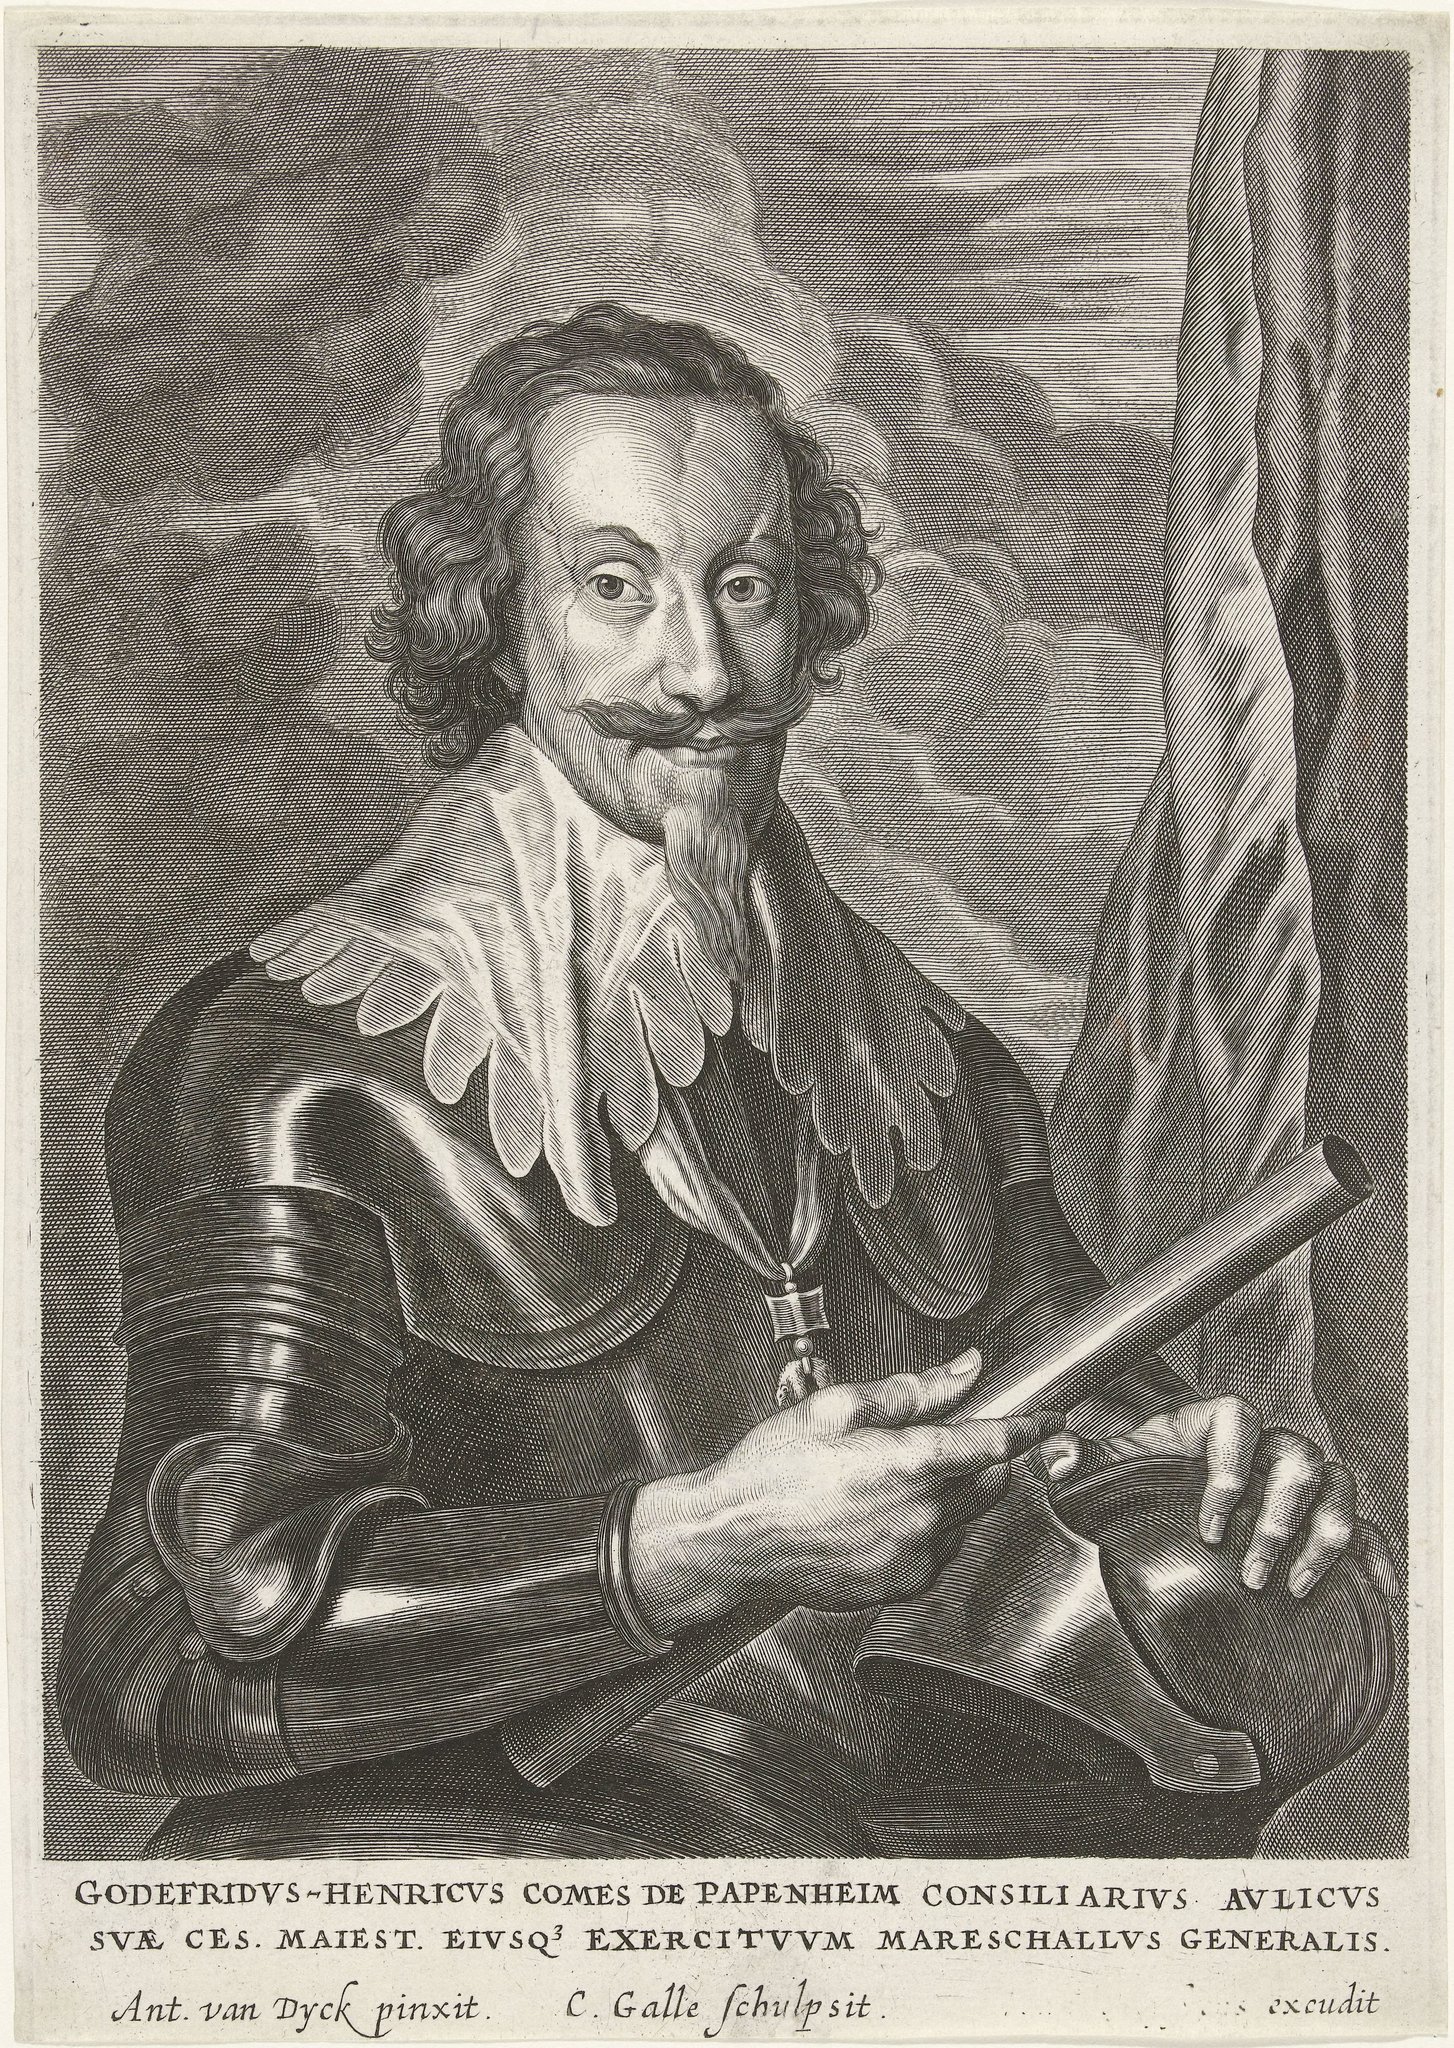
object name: print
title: Portret van Gottfried Heinrich, graaf van Pappenheim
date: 1670-1719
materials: paper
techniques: engraving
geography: antwerp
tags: historical persons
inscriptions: collector's mark: Lugt 2228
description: Portret van Gottfried Heinrich, graaf van Pappenheim, met ketting van het gulden vlies en commandostaf, voor een achtergrond van wolken.